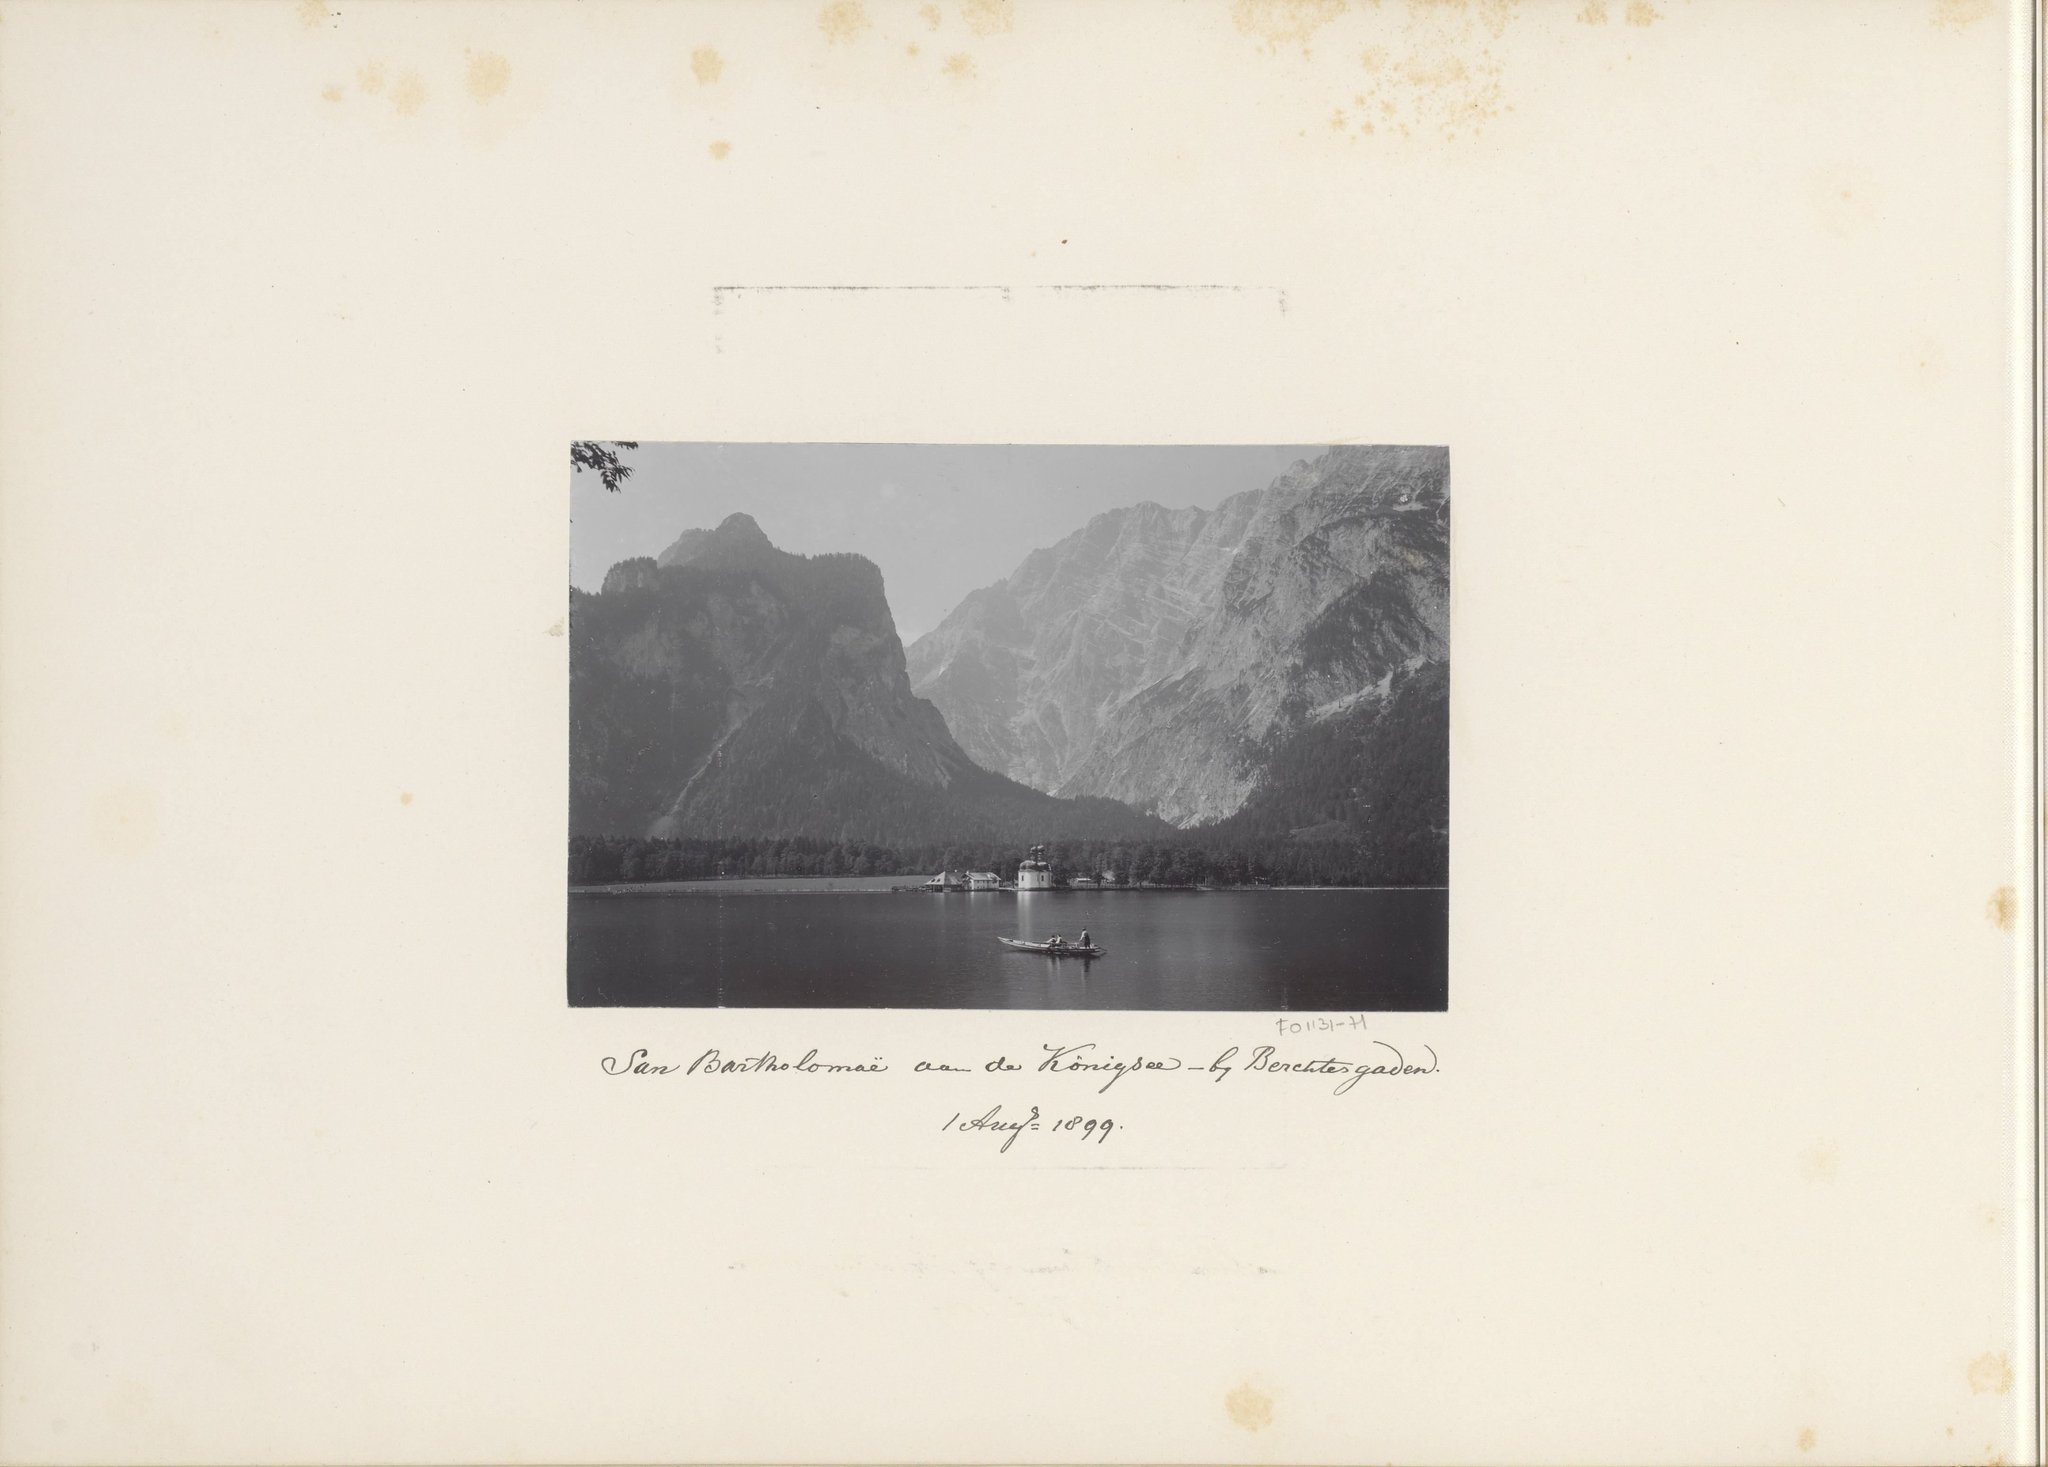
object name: photograph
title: Gezicht op de Königssee, de Sint-Bartholomeüskerk en de achterliggende bergen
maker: Anonymous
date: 1880-1899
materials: paper, photographic support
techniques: collodion silver print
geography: königssee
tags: lake, mountain-range, snow peaks, church (exterior) - qq - small church, chapel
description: Onderdeel van Reisalbum met bezienswaardigheden in Duitsland, Oostenrijk, Zwitserland, Luxemburg en België.